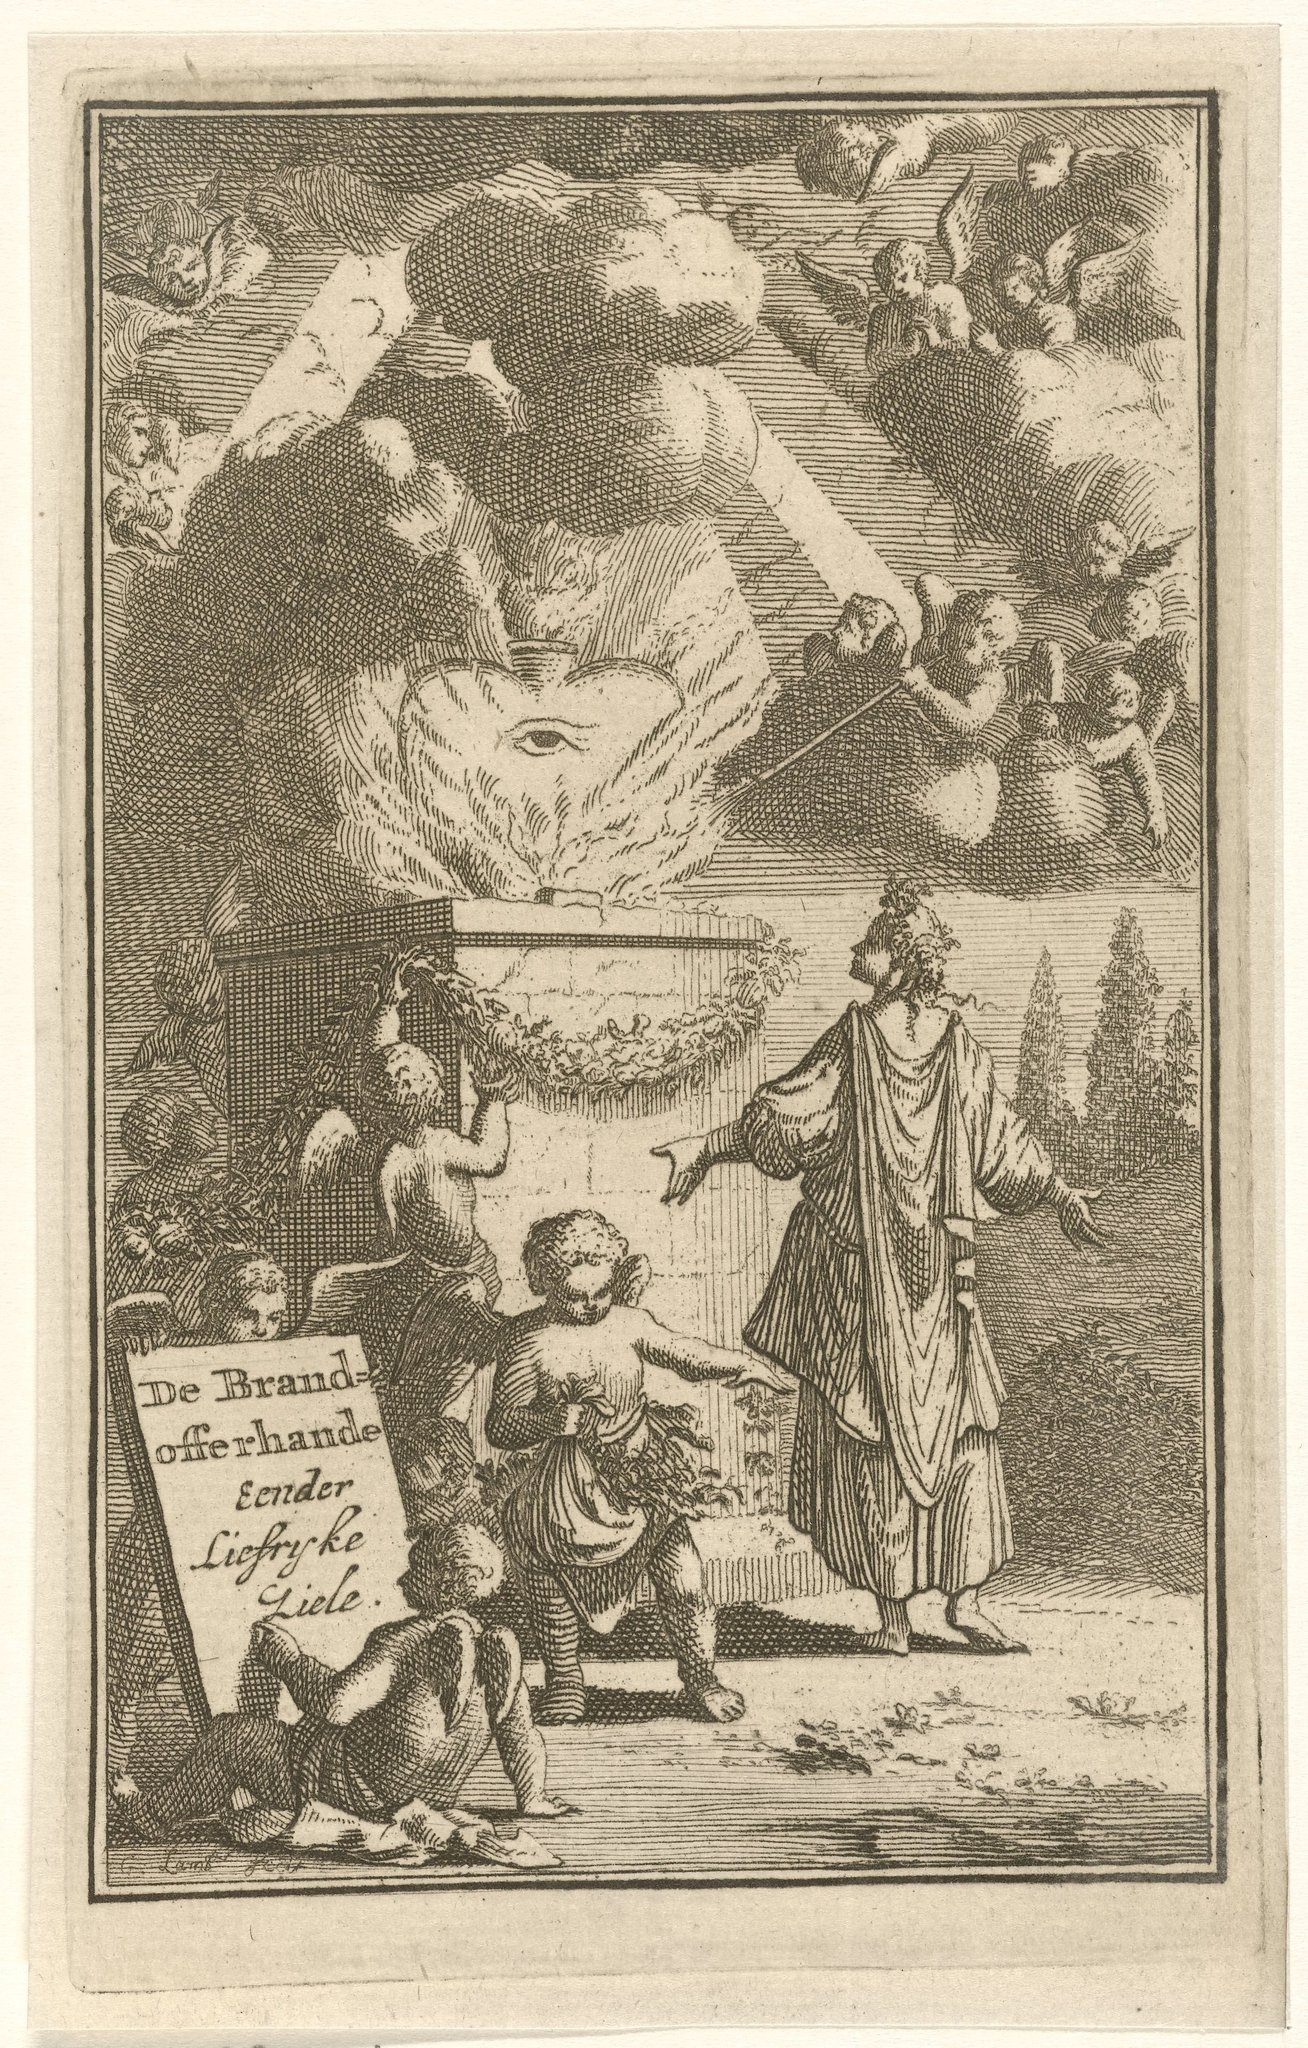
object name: book illustration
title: Brandend hart op een altaar aanbeden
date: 1715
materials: paper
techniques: etching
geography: amsterdam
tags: heart, altar, cupids: 'amores', 'amoretti', 'putti'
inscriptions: collector's mark: Lugt 2228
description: Een vrouw staat in aanbidding voor een altaar waarop een groot hart brandt, symbool voor de goddelijke liefde. Op het door vlammen omringde hart prijkt het Alziend Oog, in de lucht zweven engeltjes. Naast de vrouw strooien engelen bloemen en versieren het altaar.